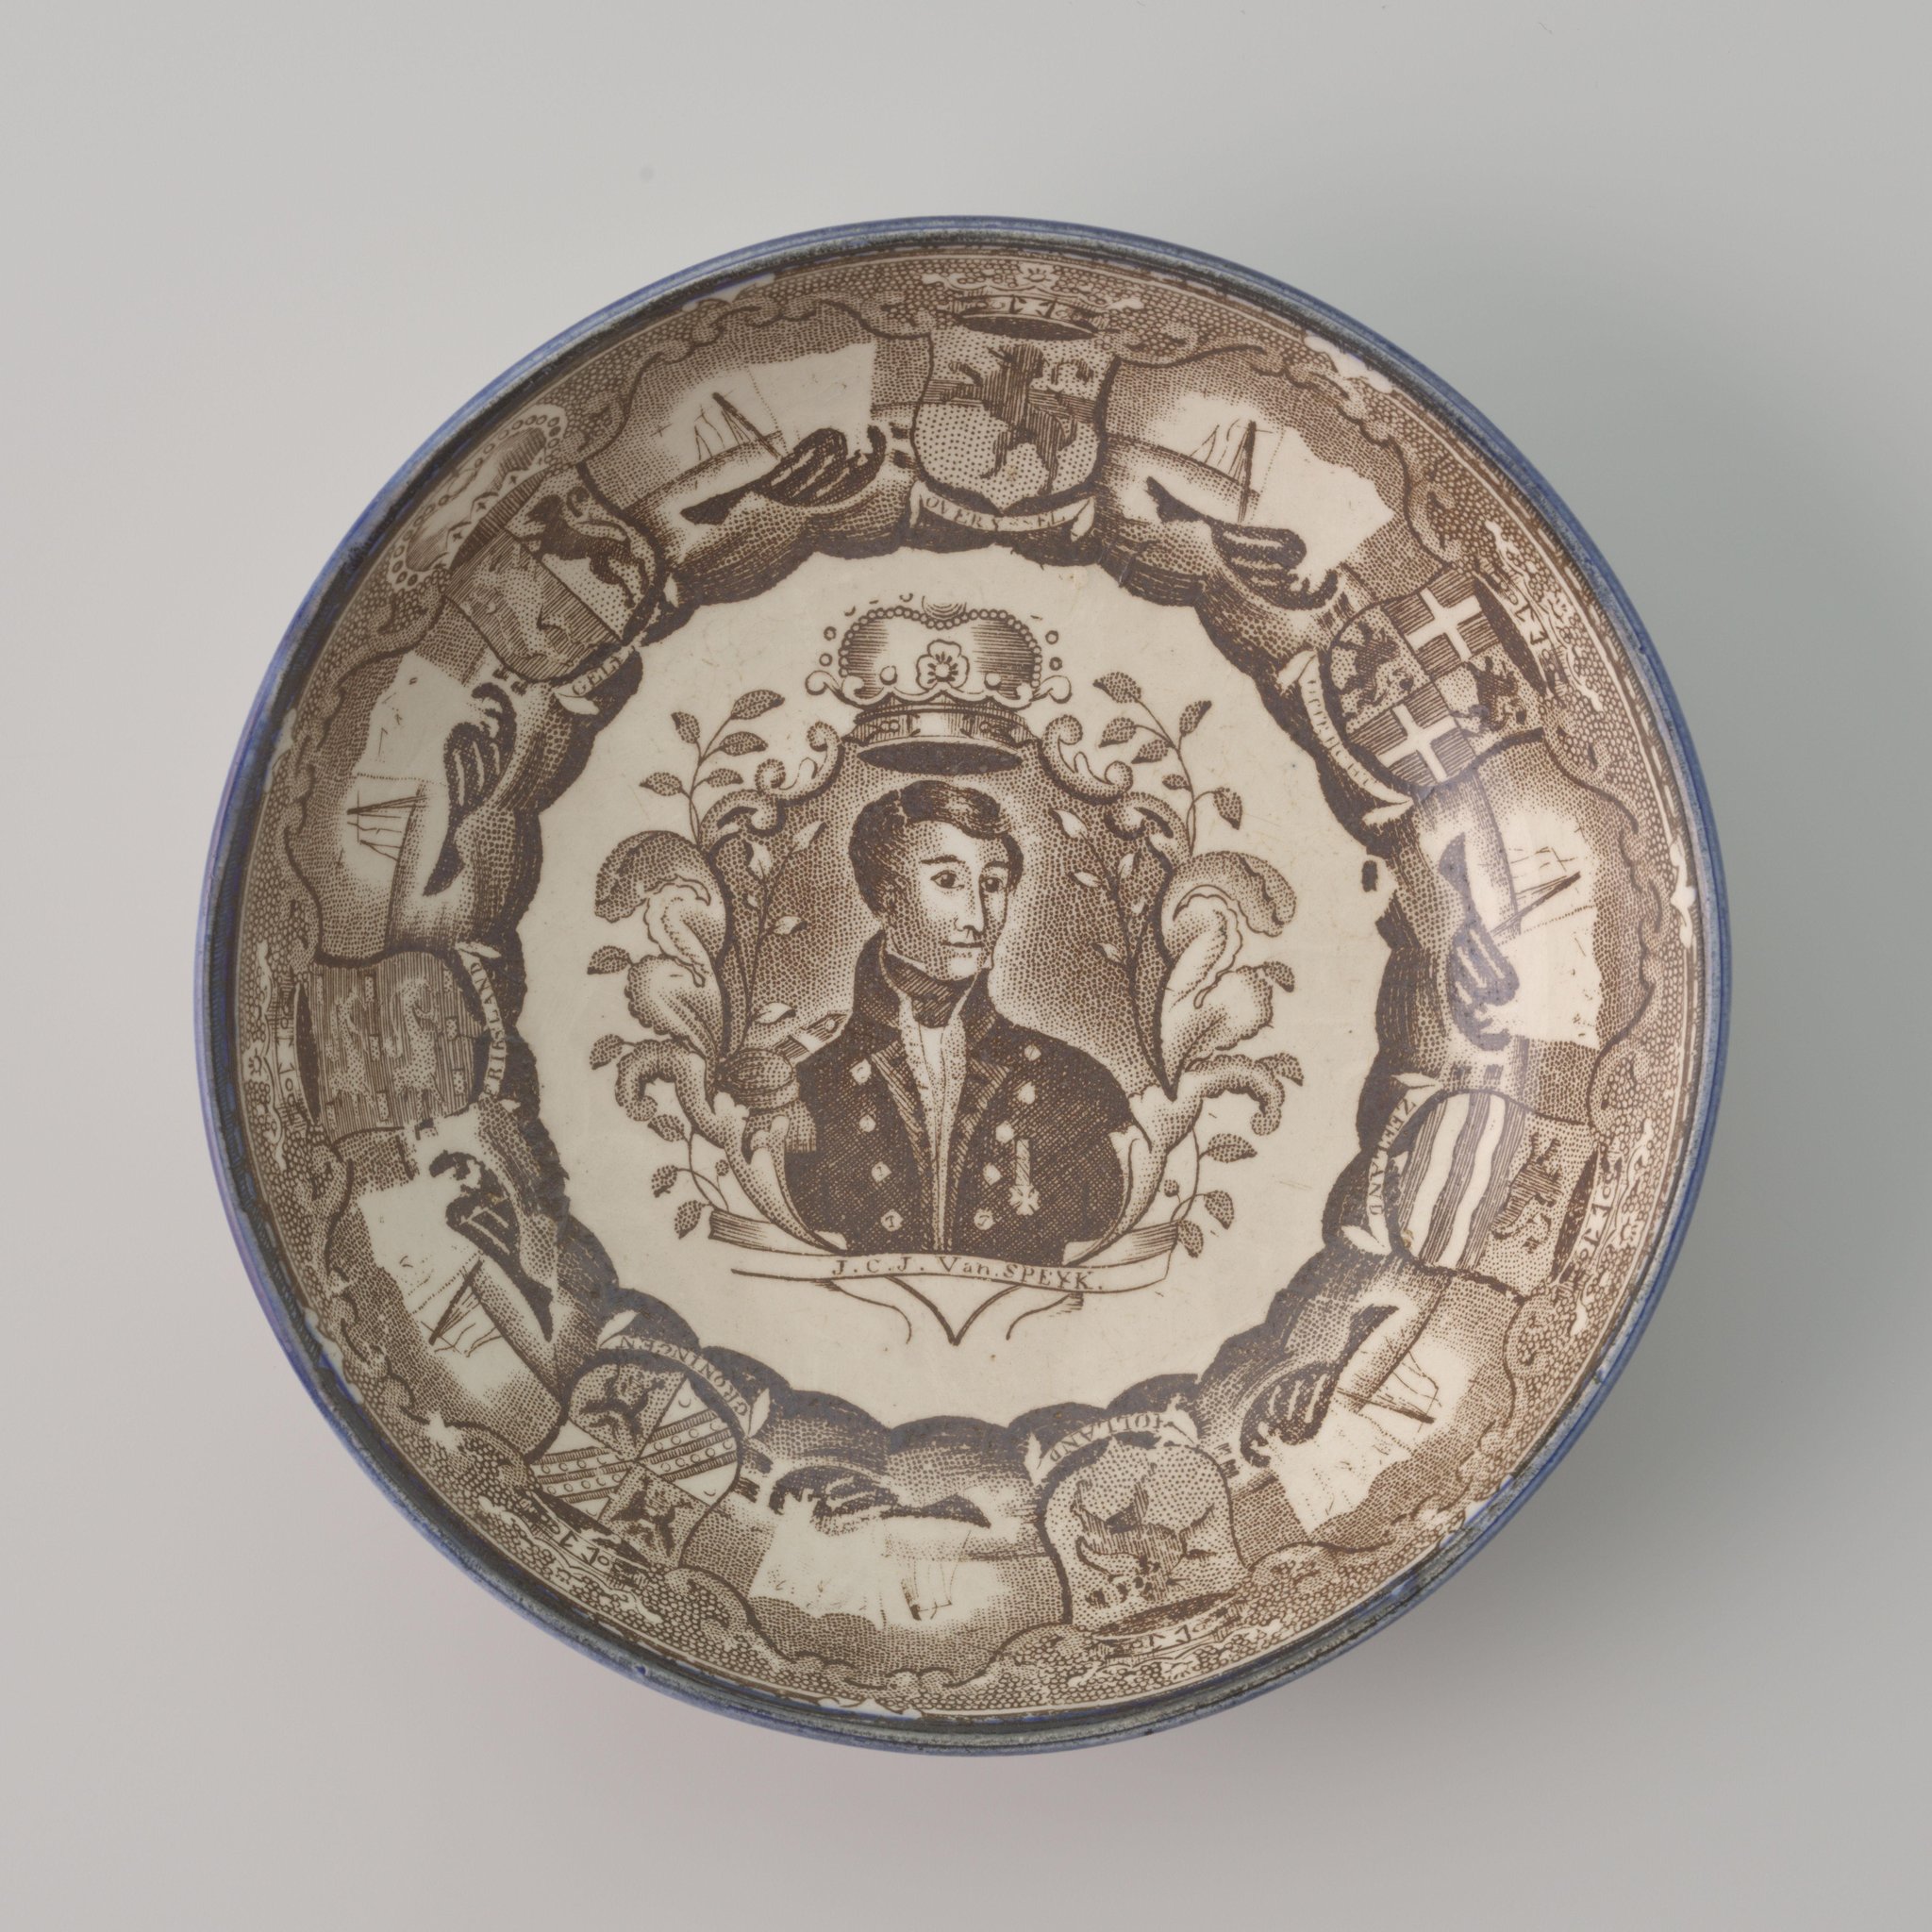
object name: kop en schotel, kop en schotel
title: Schotel van hardgebakken aardewerk met een bruine transfer als decoratie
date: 1831-1840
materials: earthenware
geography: sunderland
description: Schotel van hardgebakken aardewerk. De schotel is rond. De schotel heeft een voorstelling van een zinkend schip en wapens met als onderschrift de namen van de provincies. De schotel heeft een afbeelding van een portretbuste met een banderol waarop geschreven JCJ van Speyk. De schotels zijn gemerkt: Scott.